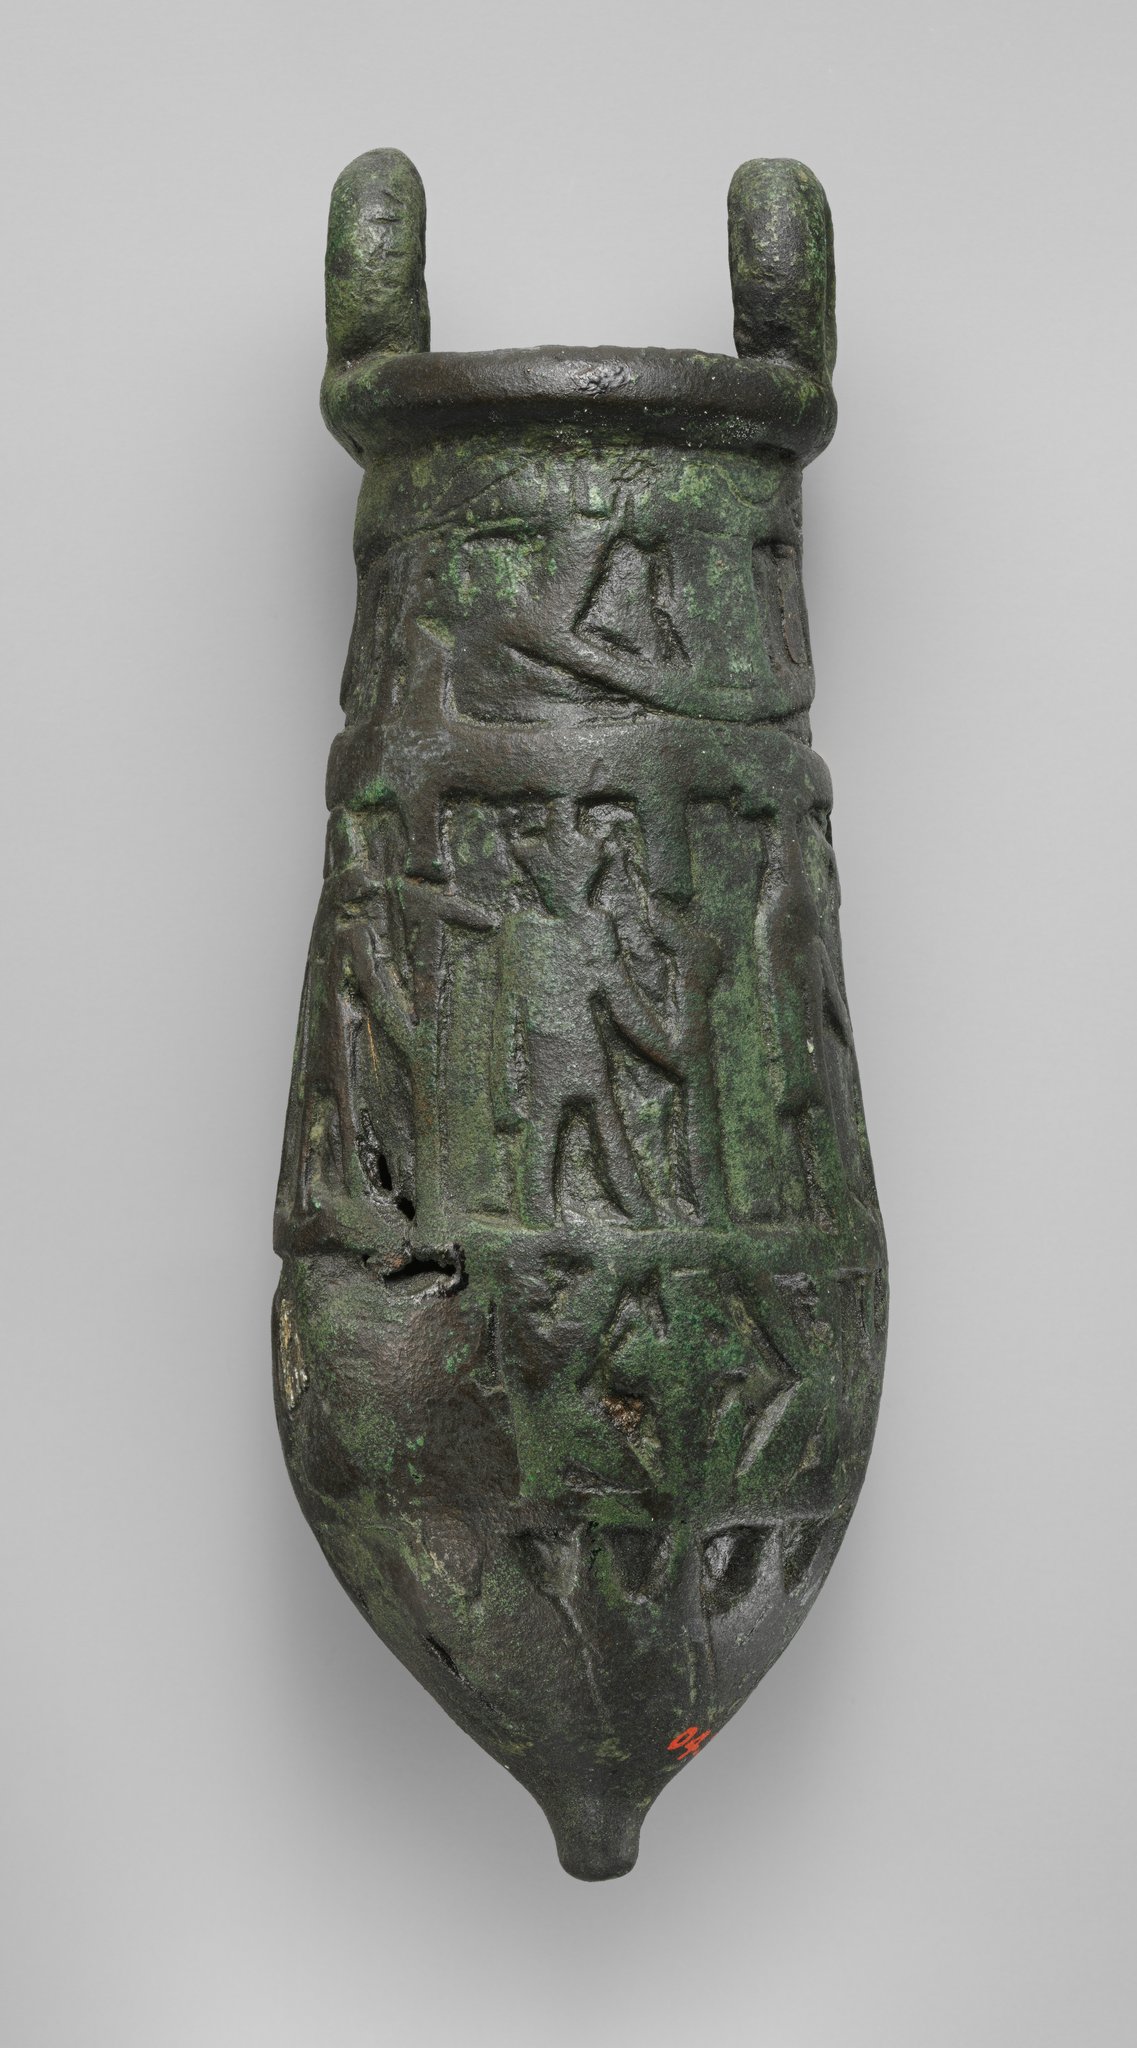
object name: situla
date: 600 BCE-100 CE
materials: copper alloy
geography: egypt